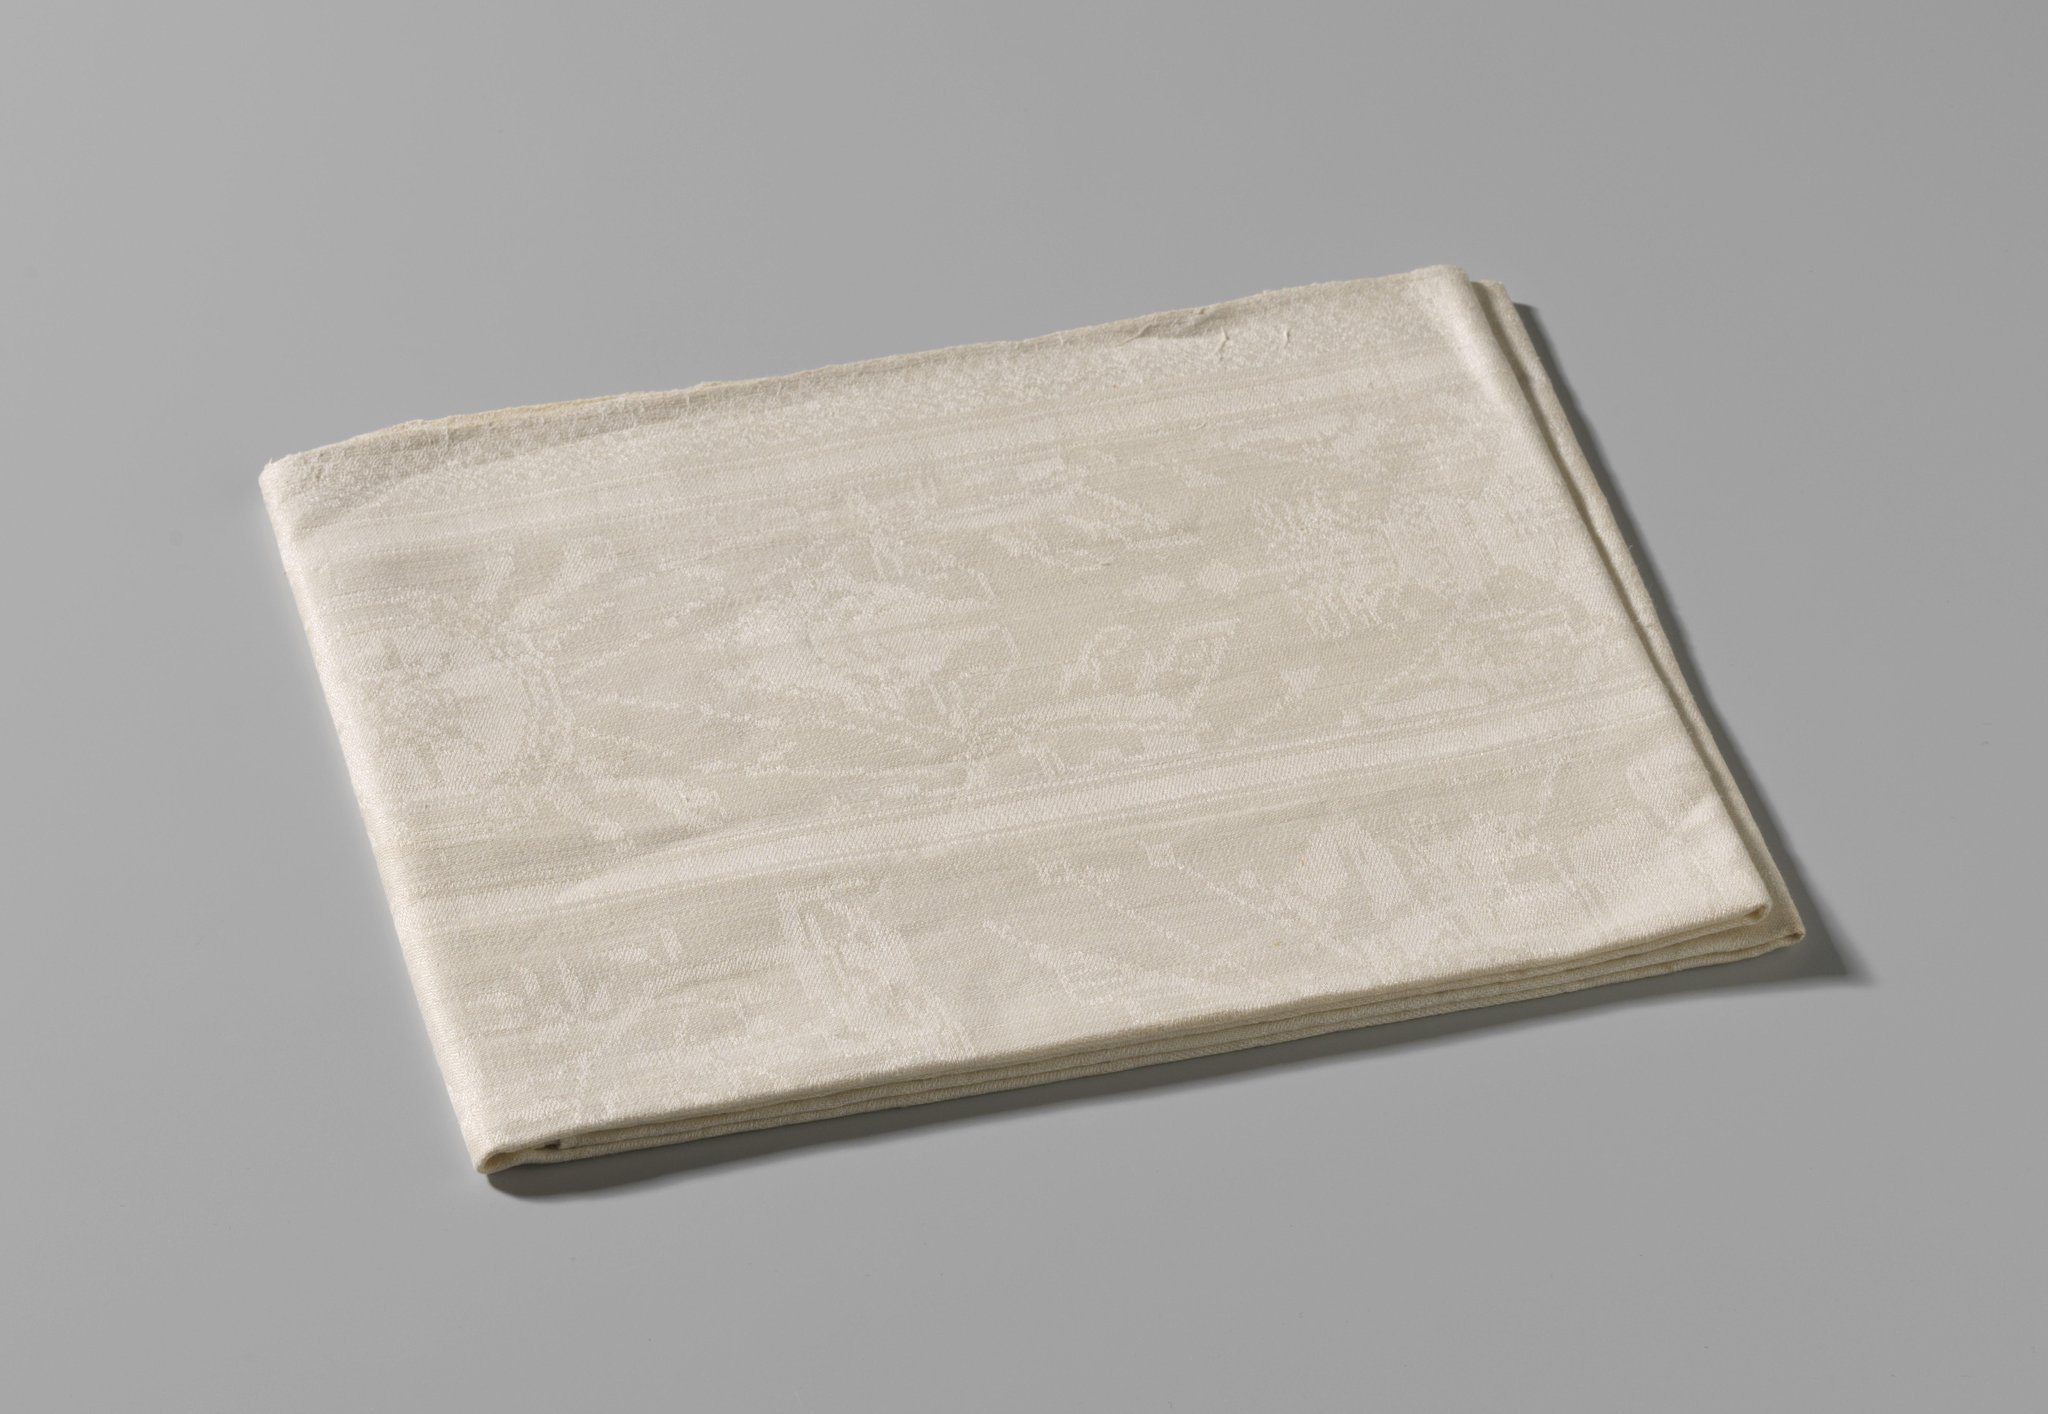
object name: napkin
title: Servet met de slag bij Malplaquet en het ruiterportret en wapen van John Churchill hertog van Marlborough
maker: Anonymous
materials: linen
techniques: damask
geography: kortrijk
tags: paris, vienna, eugenius van savoye, john churchill (1e hertog van marlborough)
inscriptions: mark: ‘12’, mark: ‘AEK’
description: Servet van linnendamast met de slag bij Malplaquet en het ruiterportret en wapen van John Churchill hertog van Marlborough. Ingeweven: GEN/ MARLB/ OROUG en MALPLAQUE.